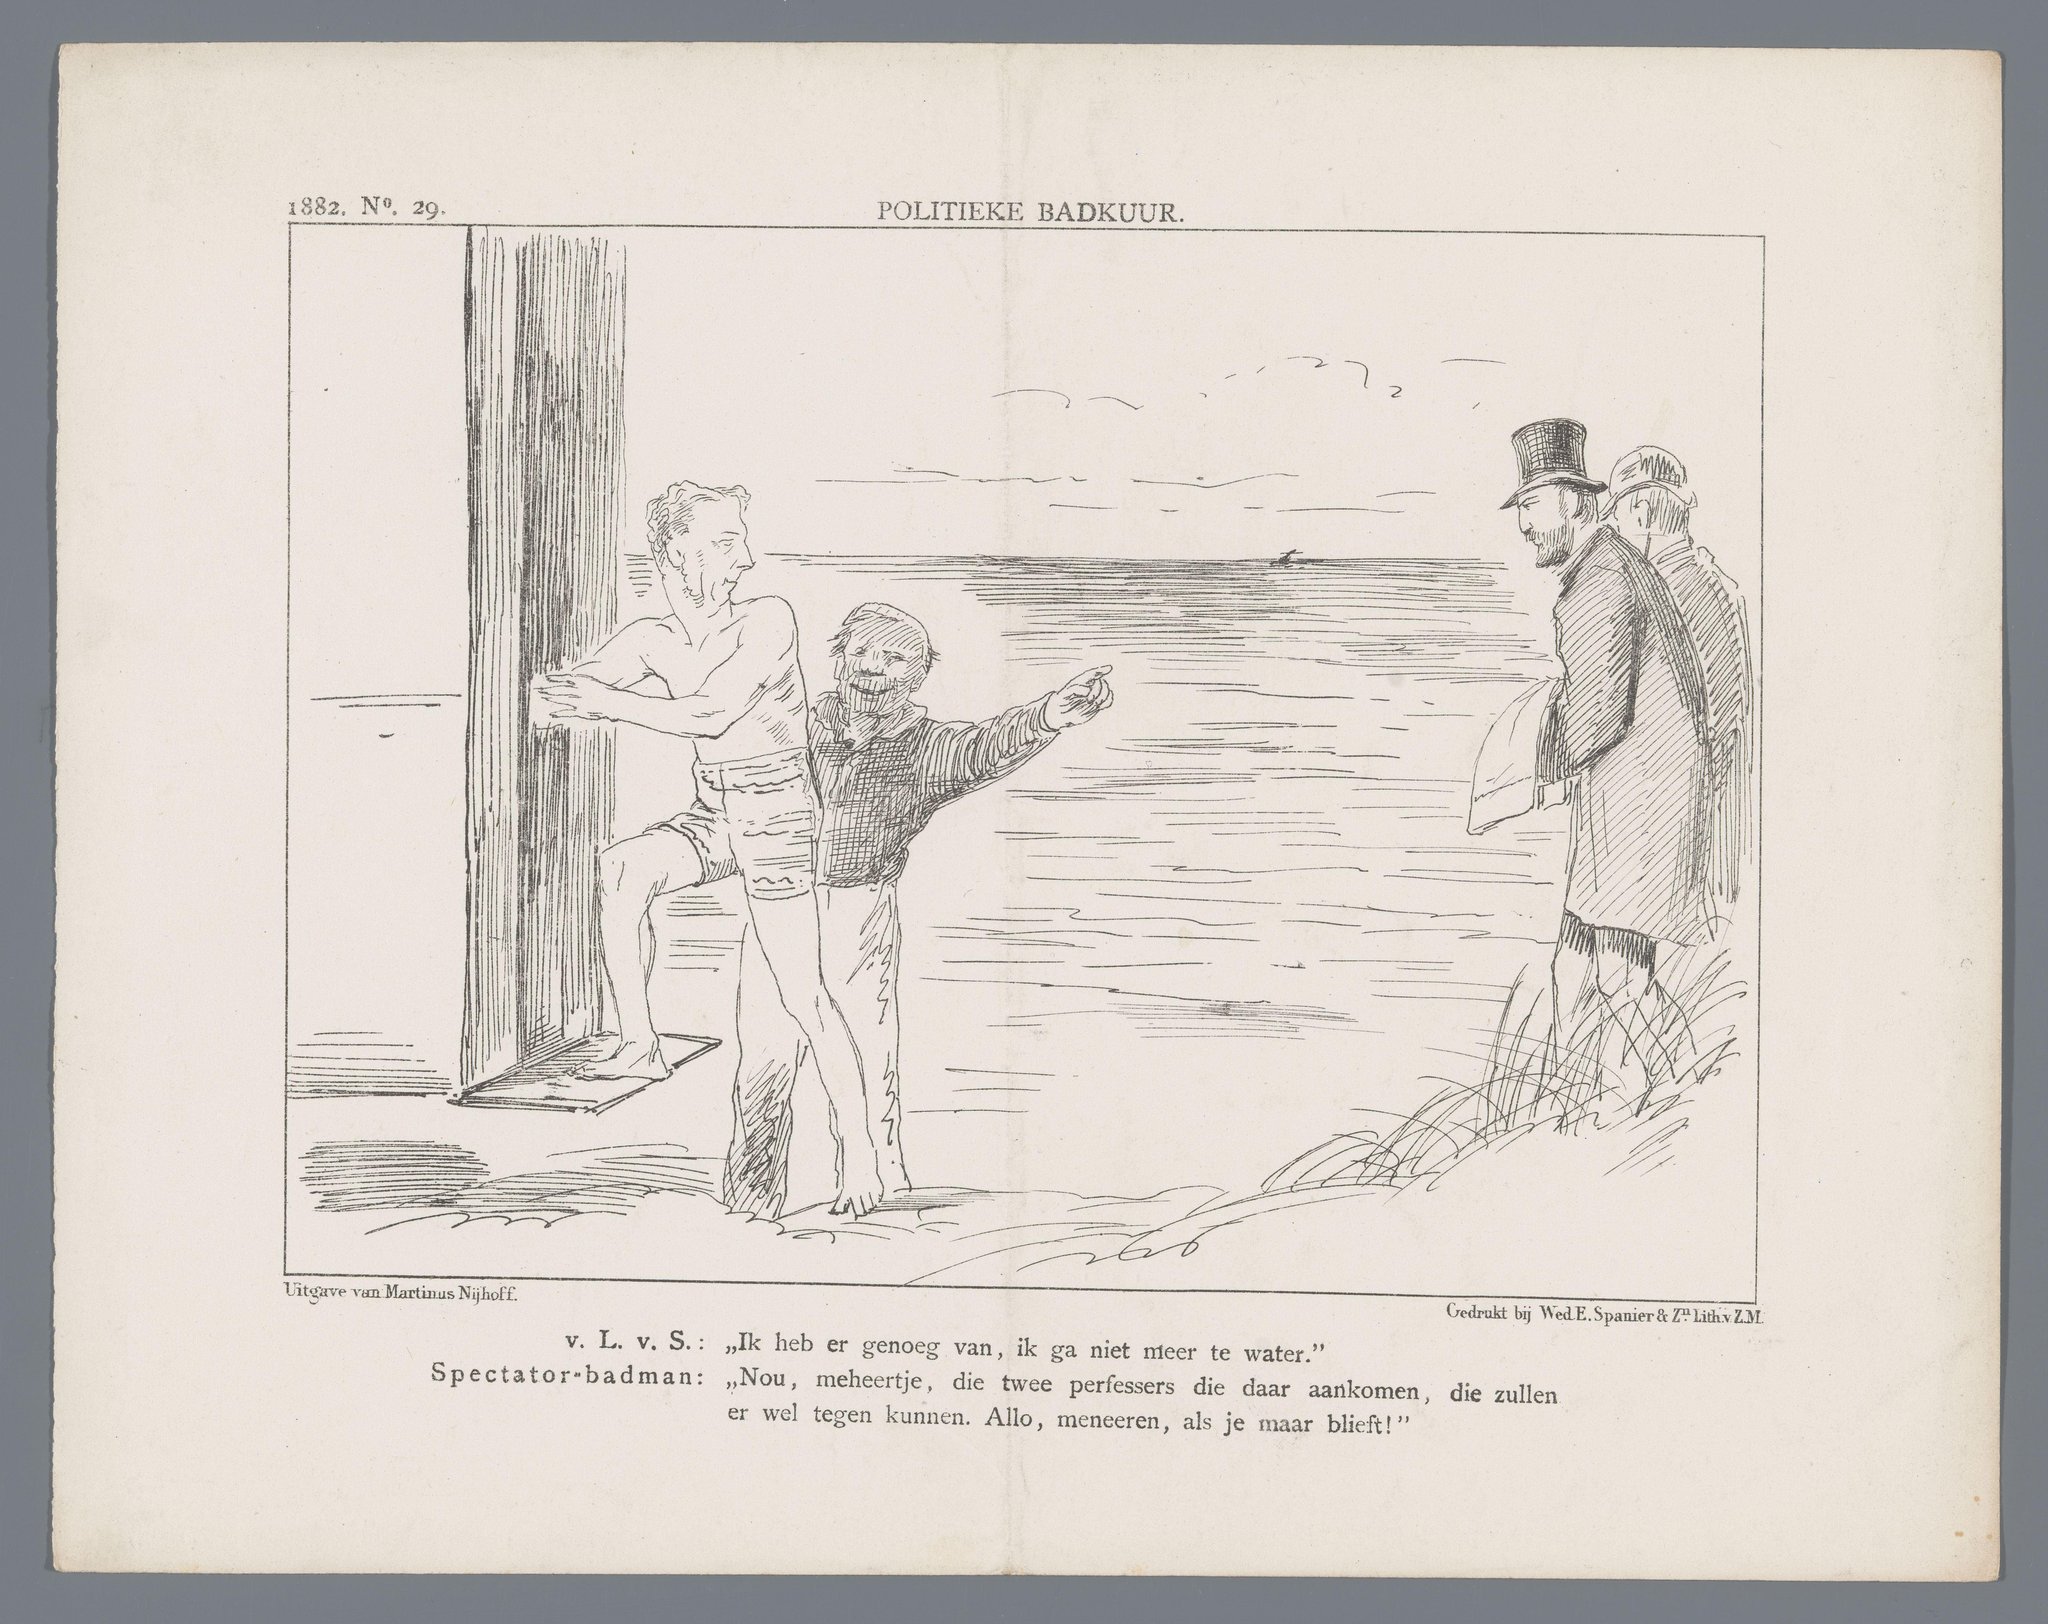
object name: cartoon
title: Politieke badkuur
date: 1882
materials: paper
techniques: lithograph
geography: netherlands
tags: minister, constantijn theodore lynden van sandenburg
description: Politieke spotprent met minister Van Lynden van Sandenburg als badgast. Plaat verschenen bij het weekblad De Nederlandsche Spectator, nr. 29, 1882.